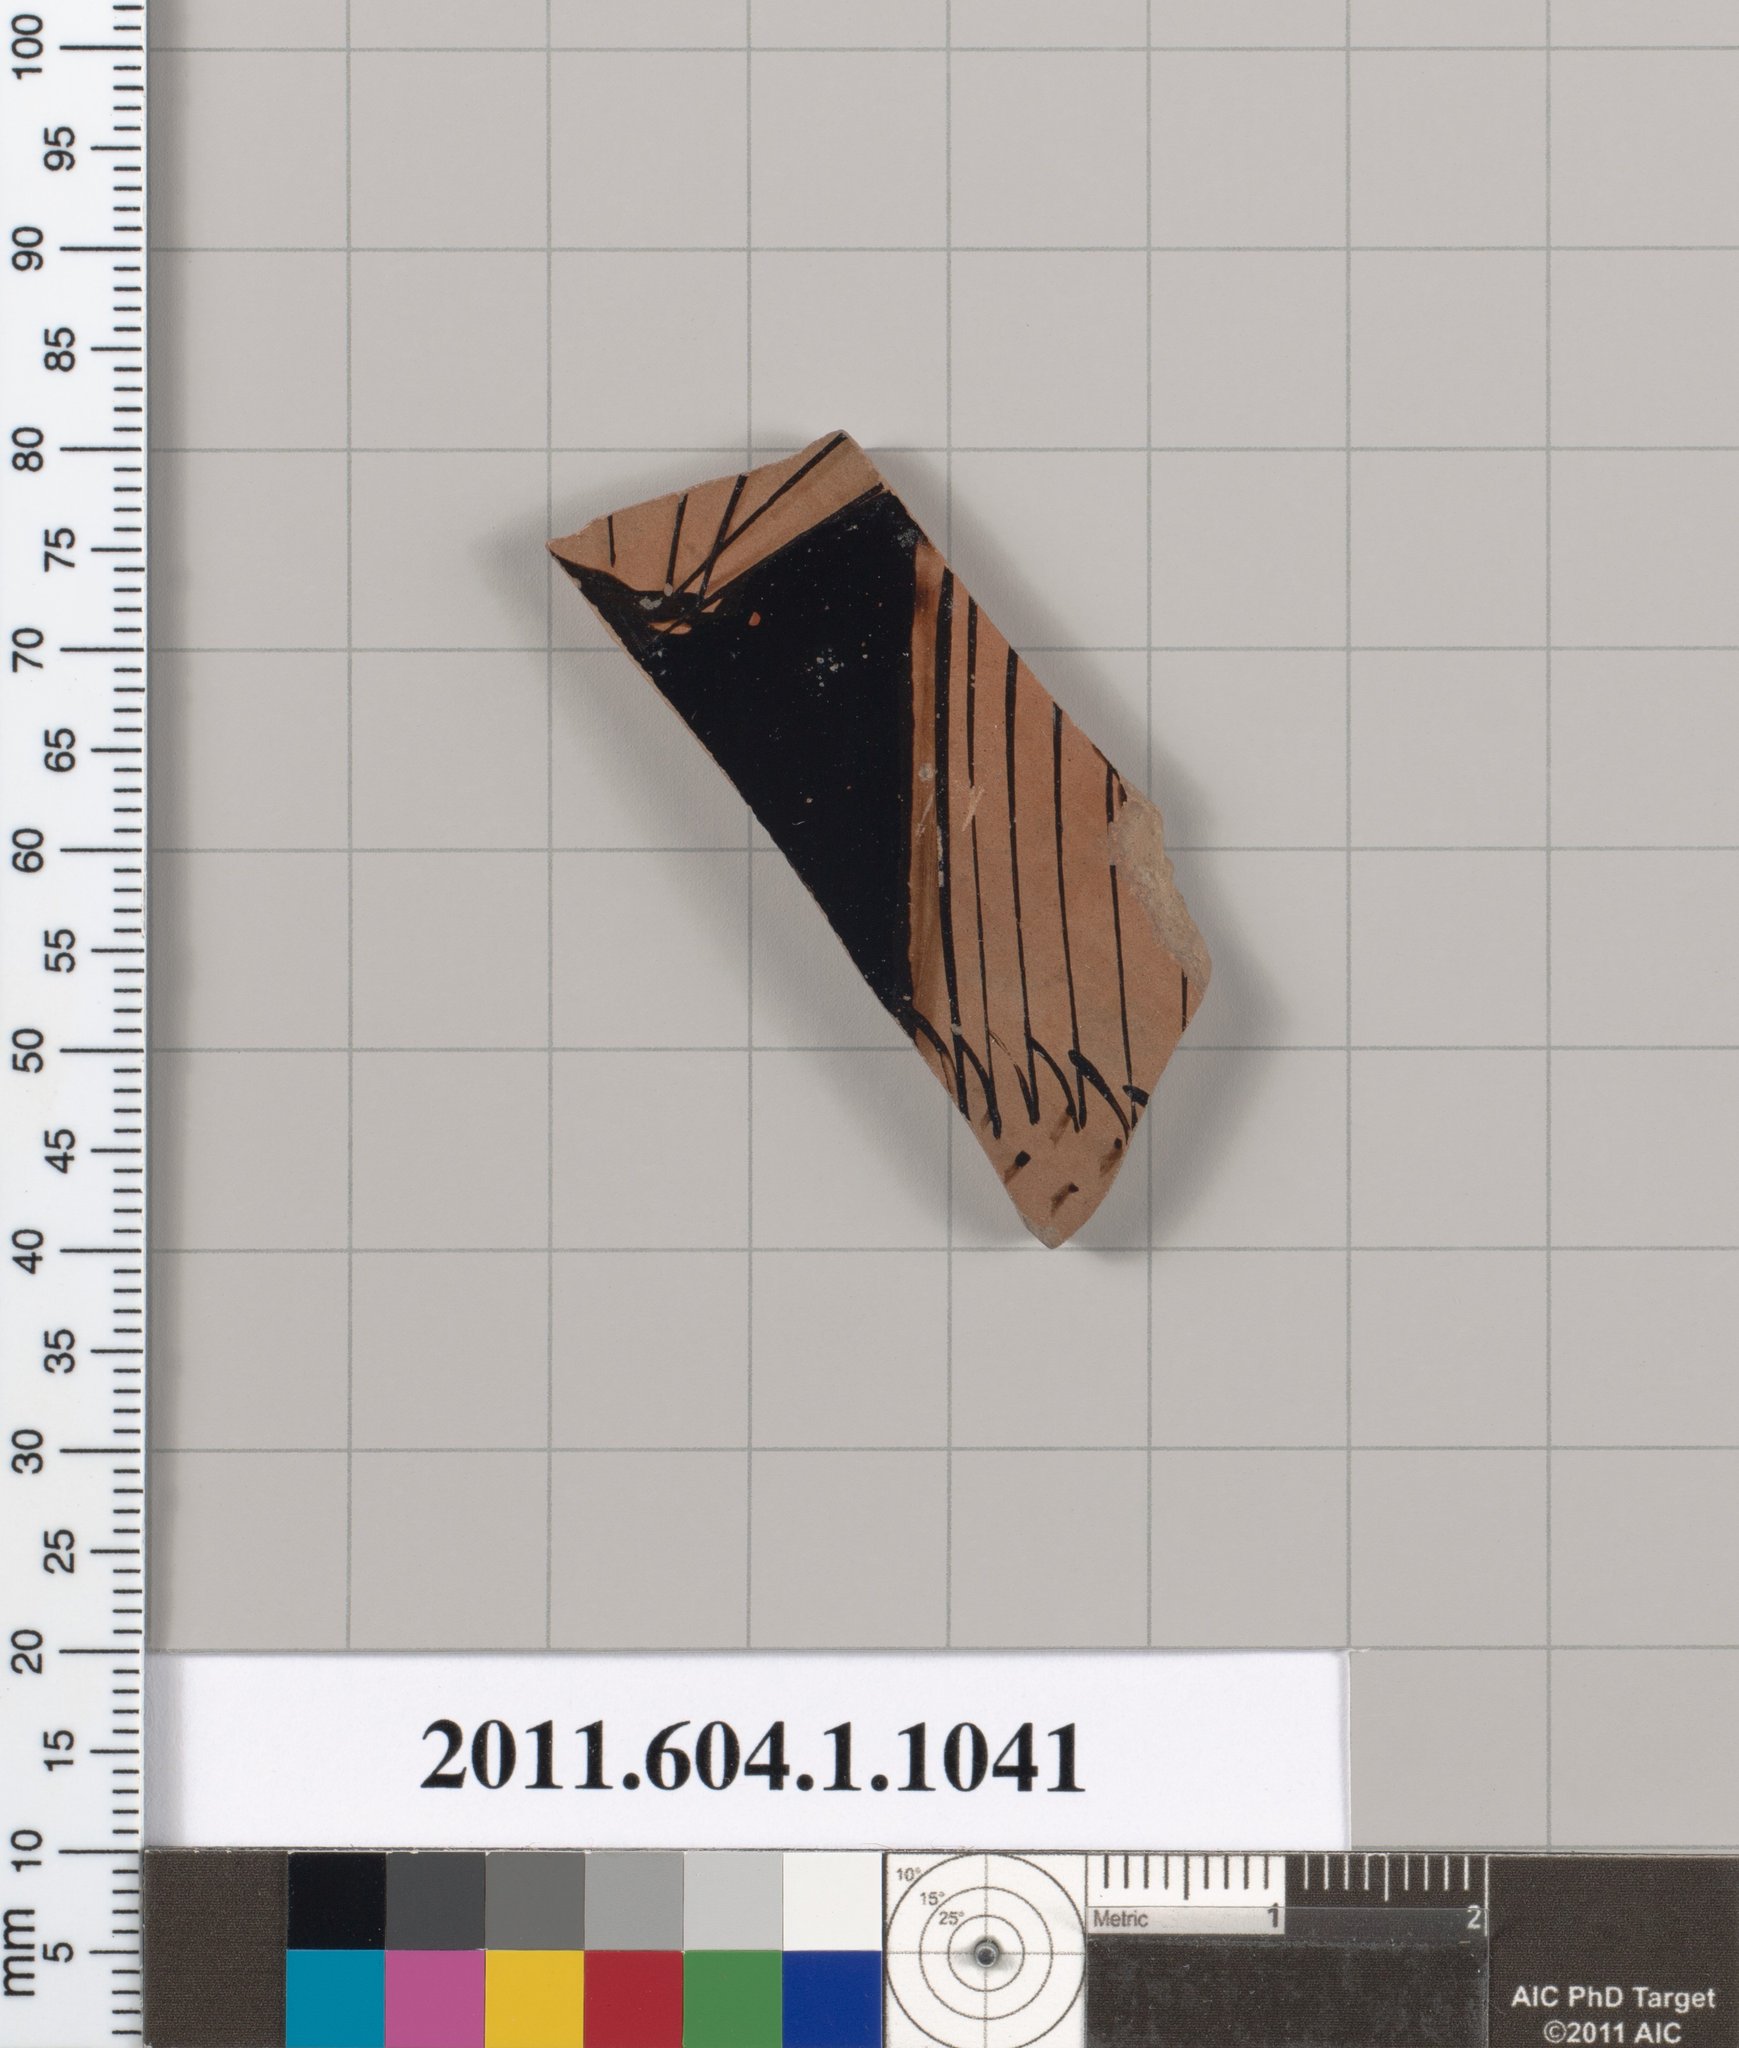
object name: kylix fragment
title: Terracotta fragment of a kylix (drinking cup)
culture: greek, attic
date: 475-451 BCE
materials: terracotta